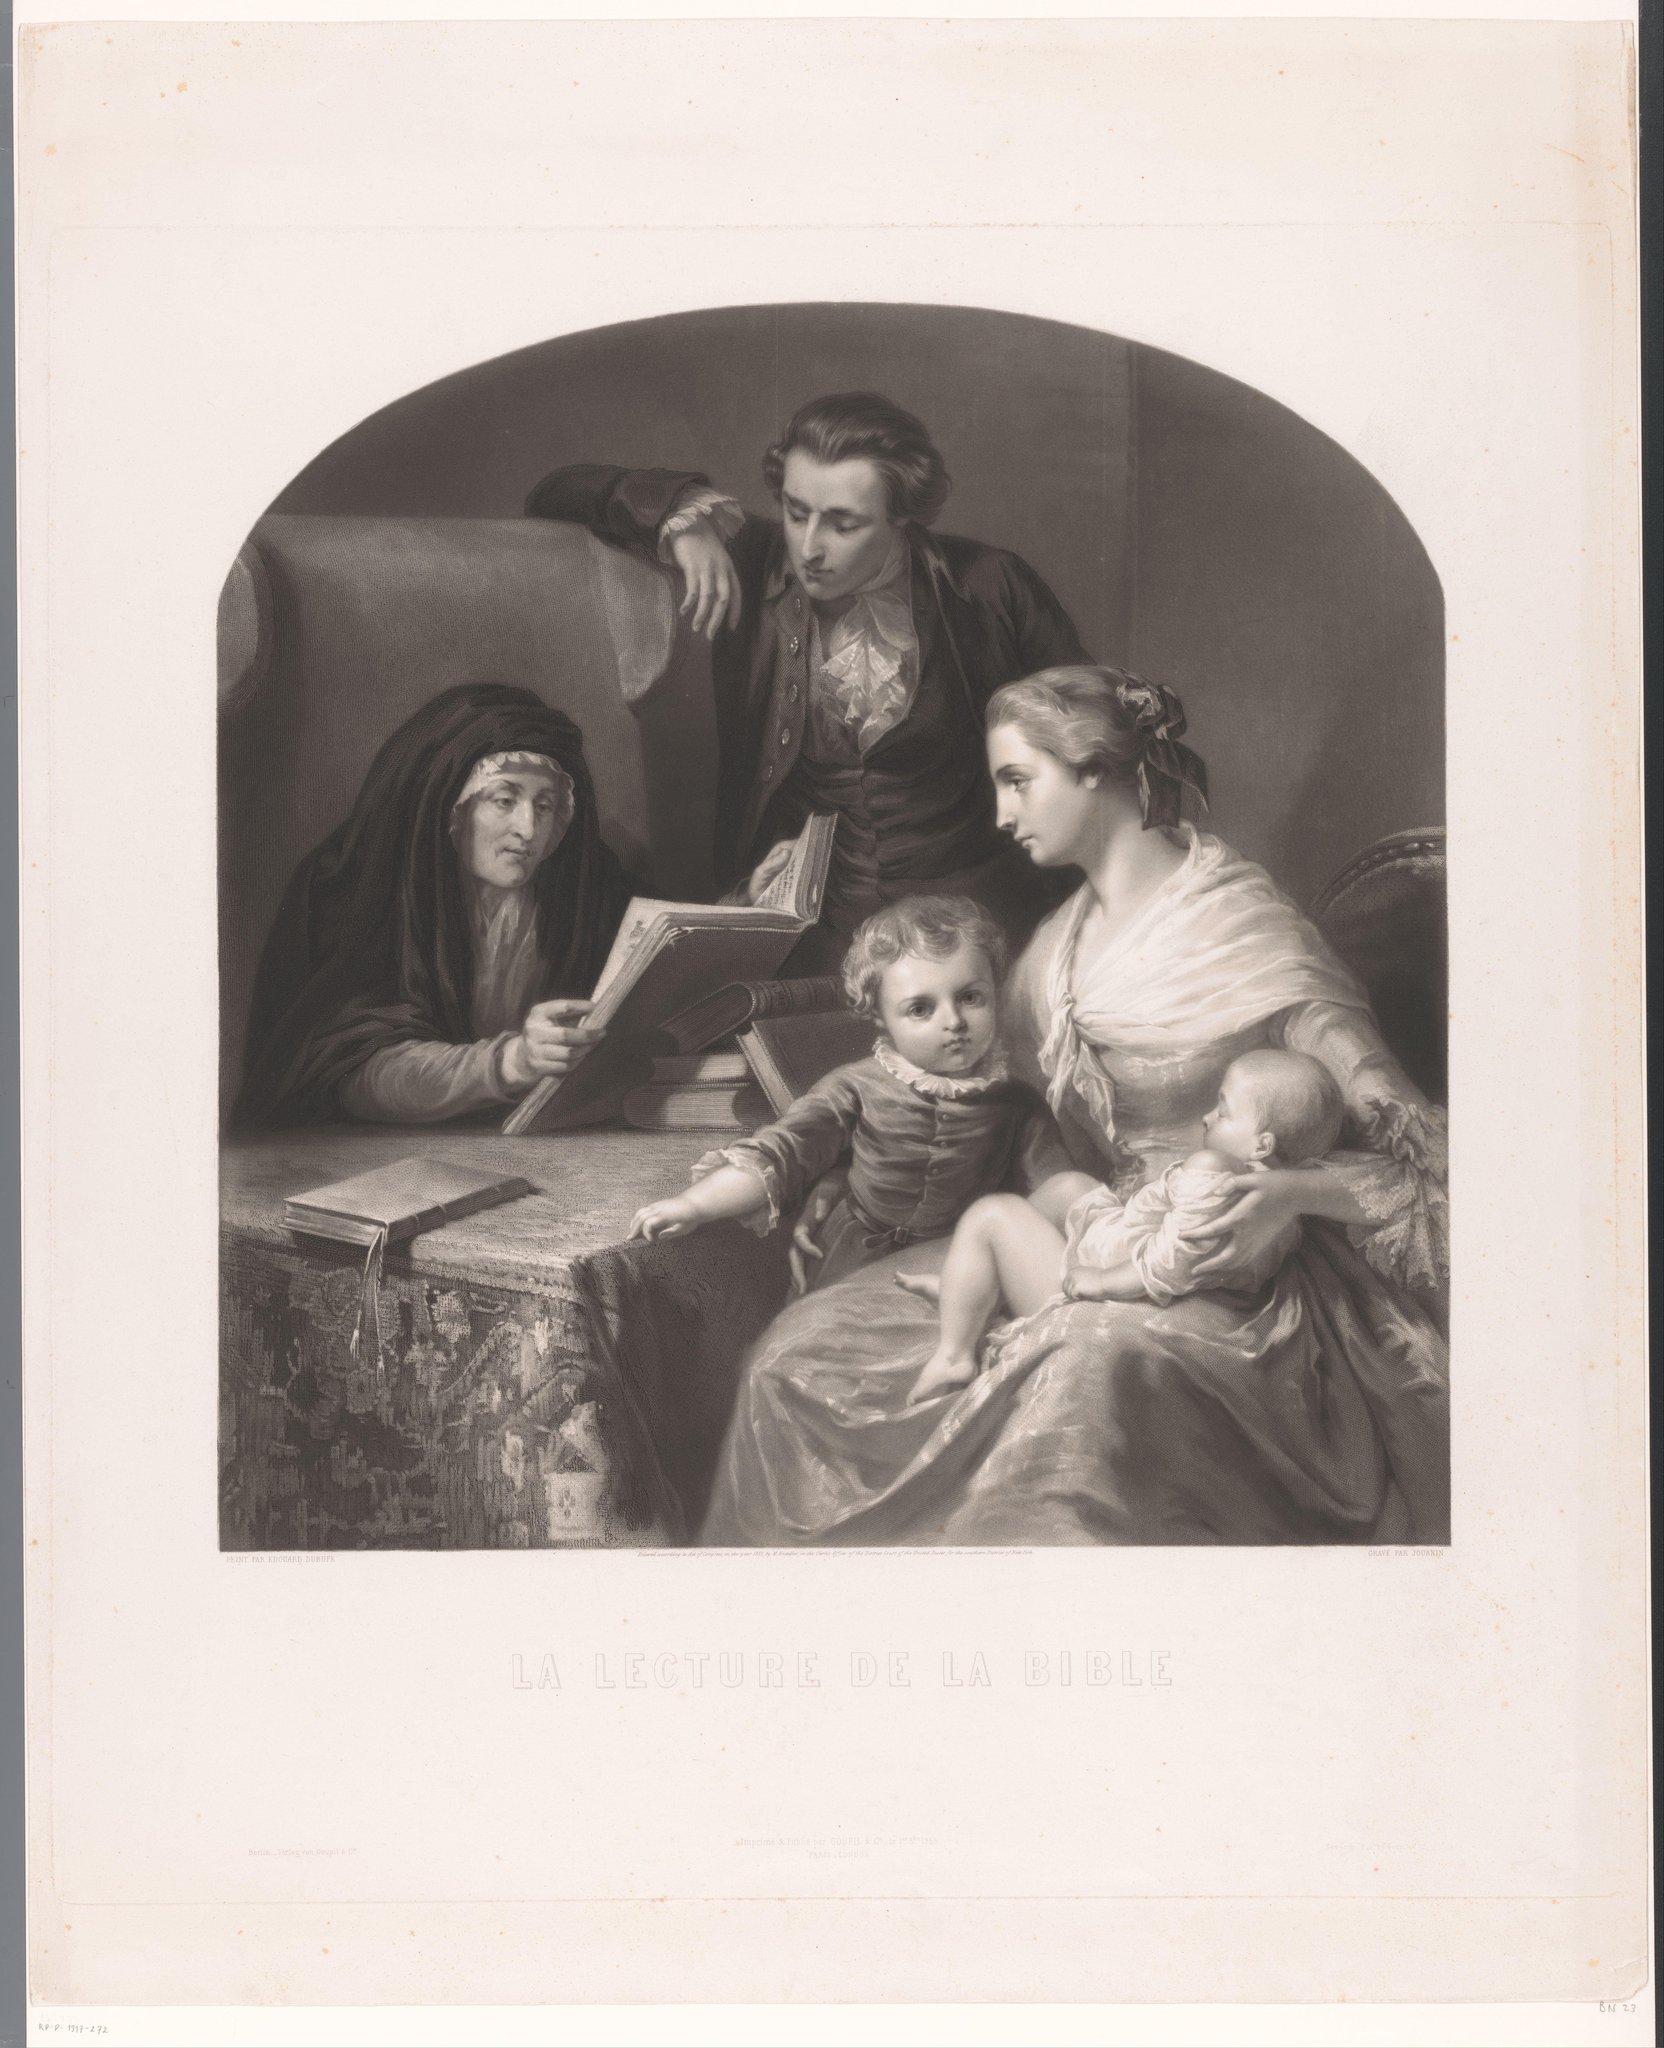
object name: print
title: La lecture de la bible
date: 1855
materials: paper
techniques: aquatint, engraving, etching, roulette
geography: new york city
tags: reading the bible or other religious books, family life at home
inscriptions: collector's mark: Lugt 2228